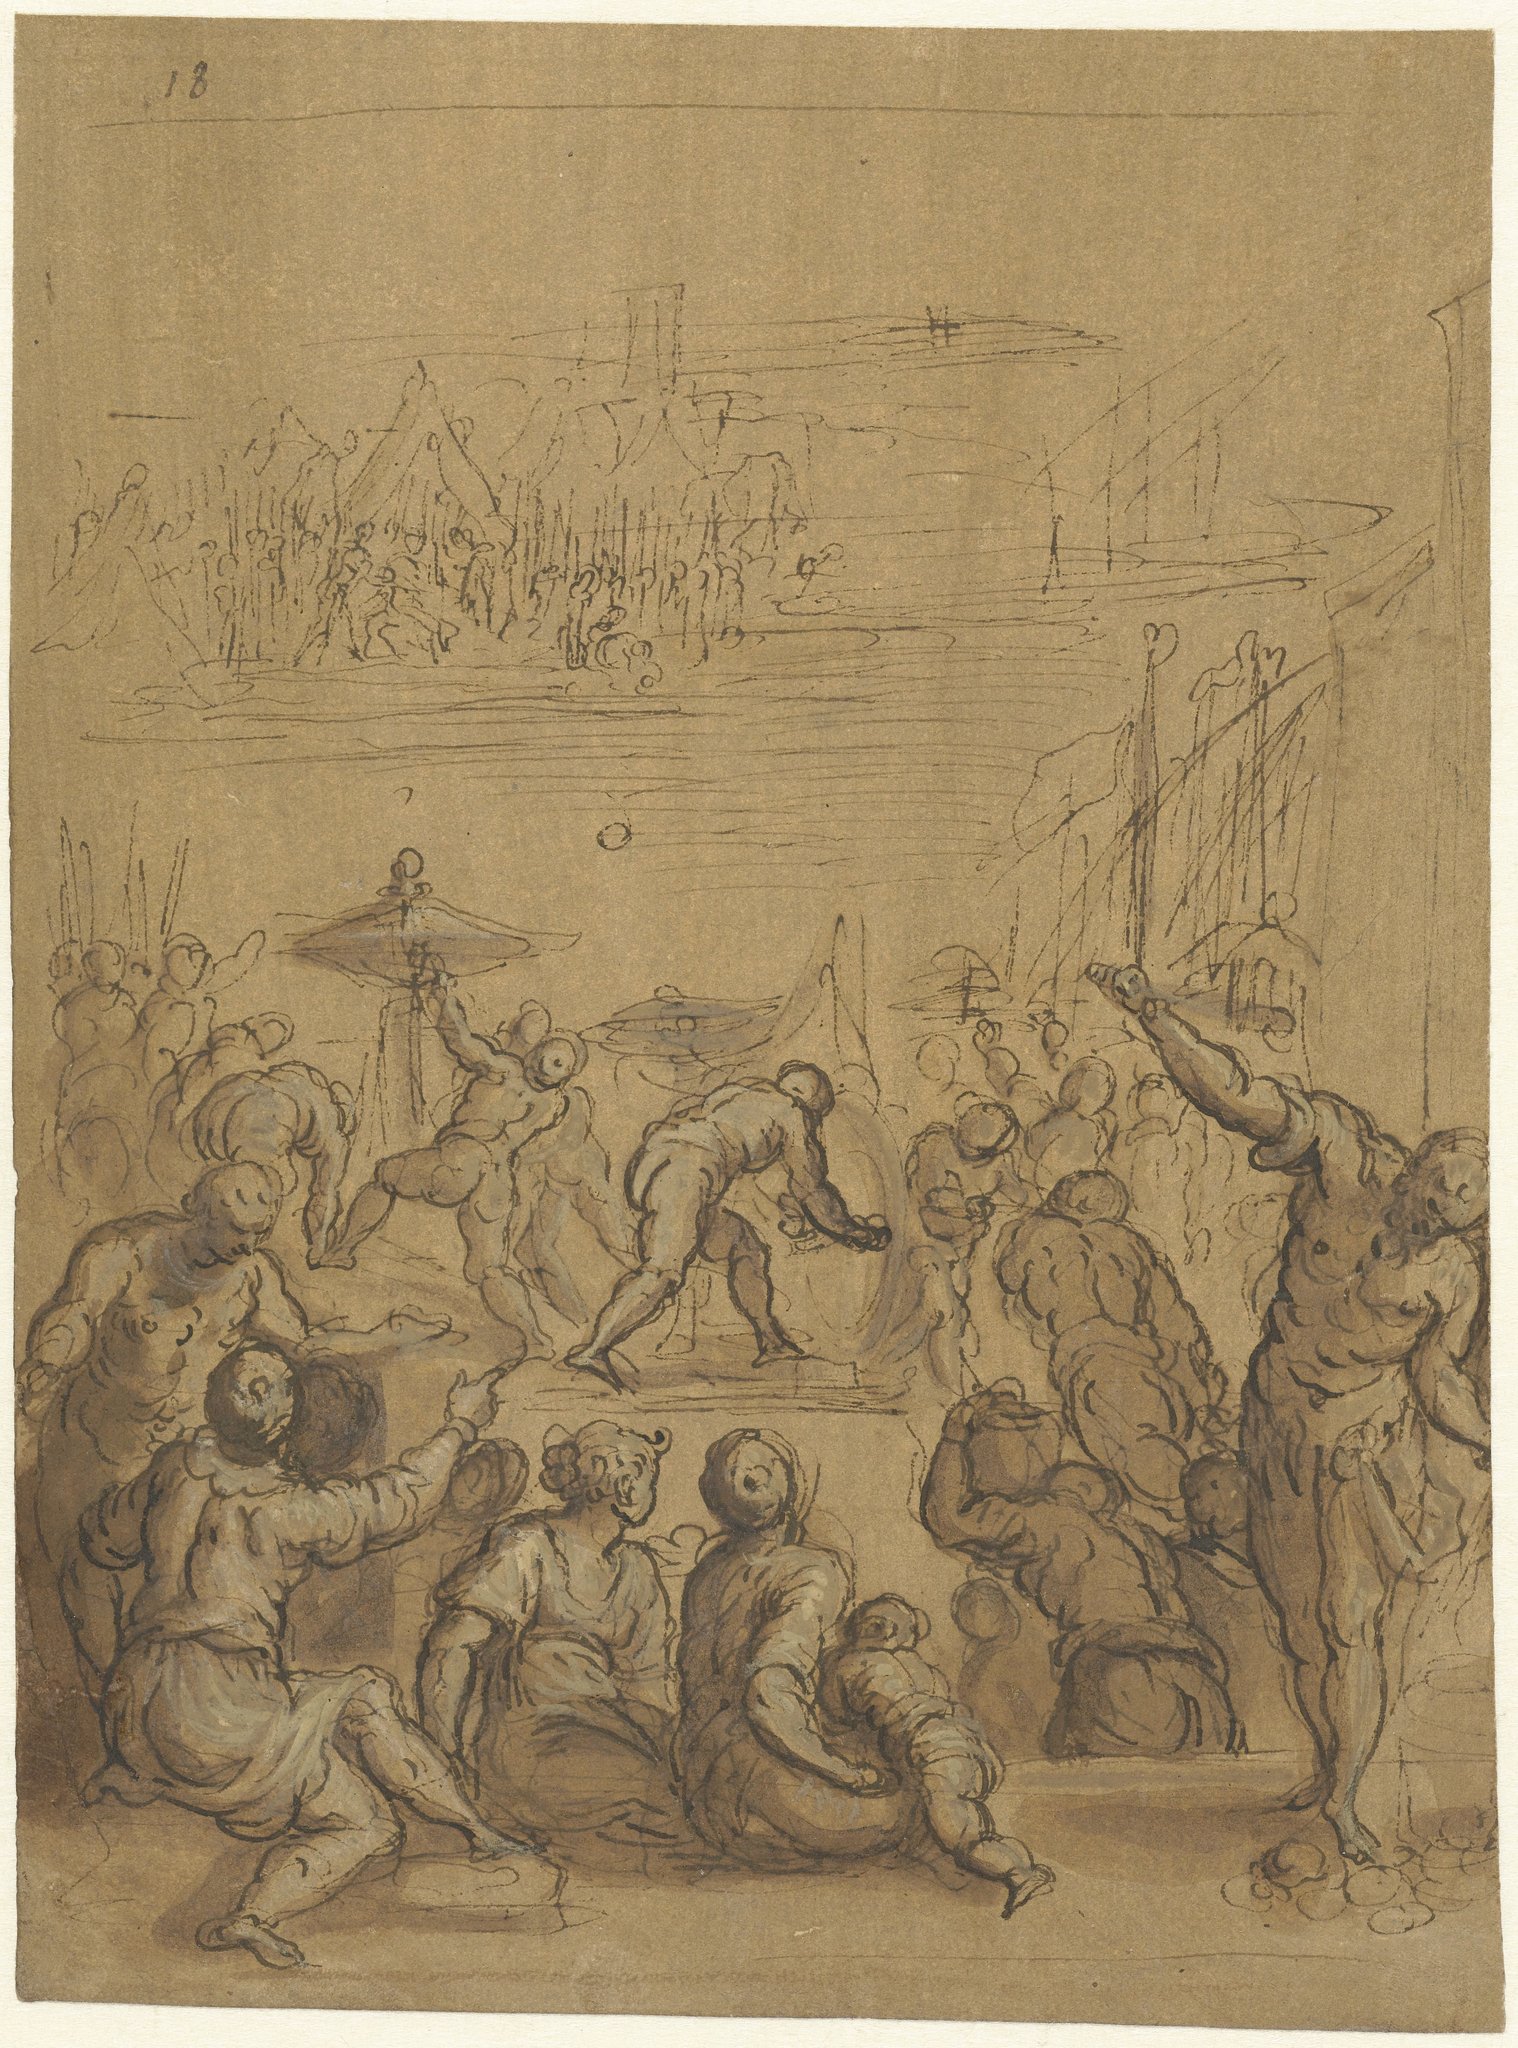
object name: drawing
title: Beleg van Venetië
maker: jacopo palma (il giovane)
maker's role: draughtsman, painter, print maker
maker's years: 1544-1628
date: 1575-1585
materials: ink, paper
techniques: brush, pen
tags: beleg van venetië door pippijn, koning van italië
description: Blad afkomstig uit een schetsboek van Palma, vroeger bijeen in de verzameling Liechtenstein.